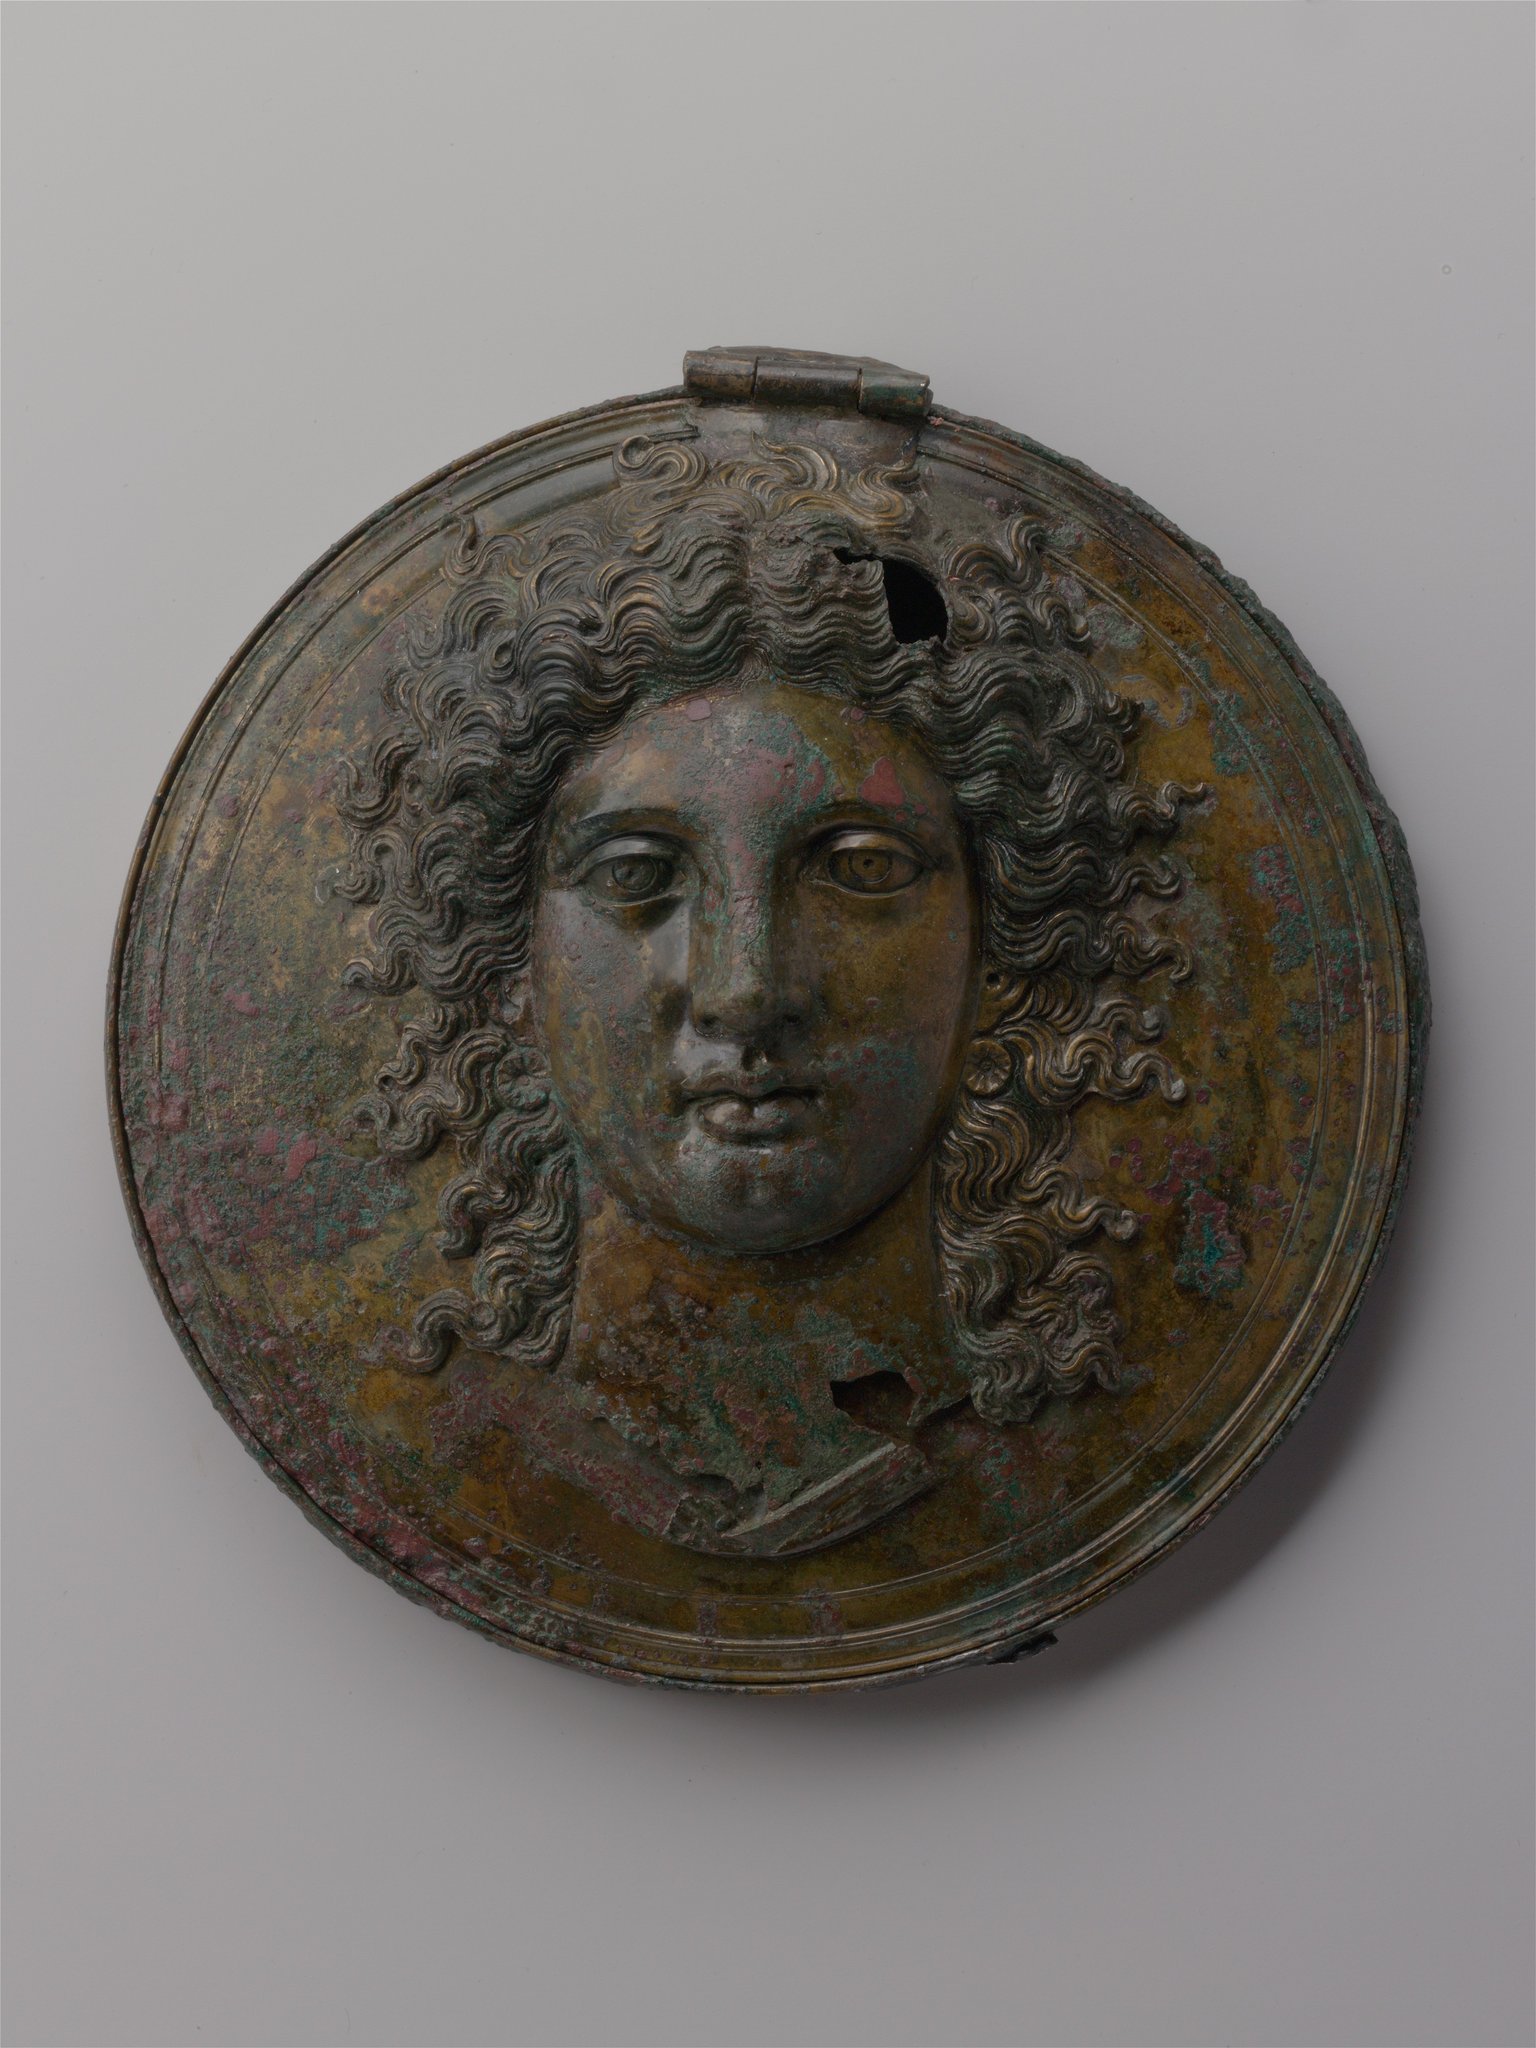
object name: mirror with head of a woman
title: Bronze box mirror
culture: greek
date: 326-350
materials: bronze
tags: women